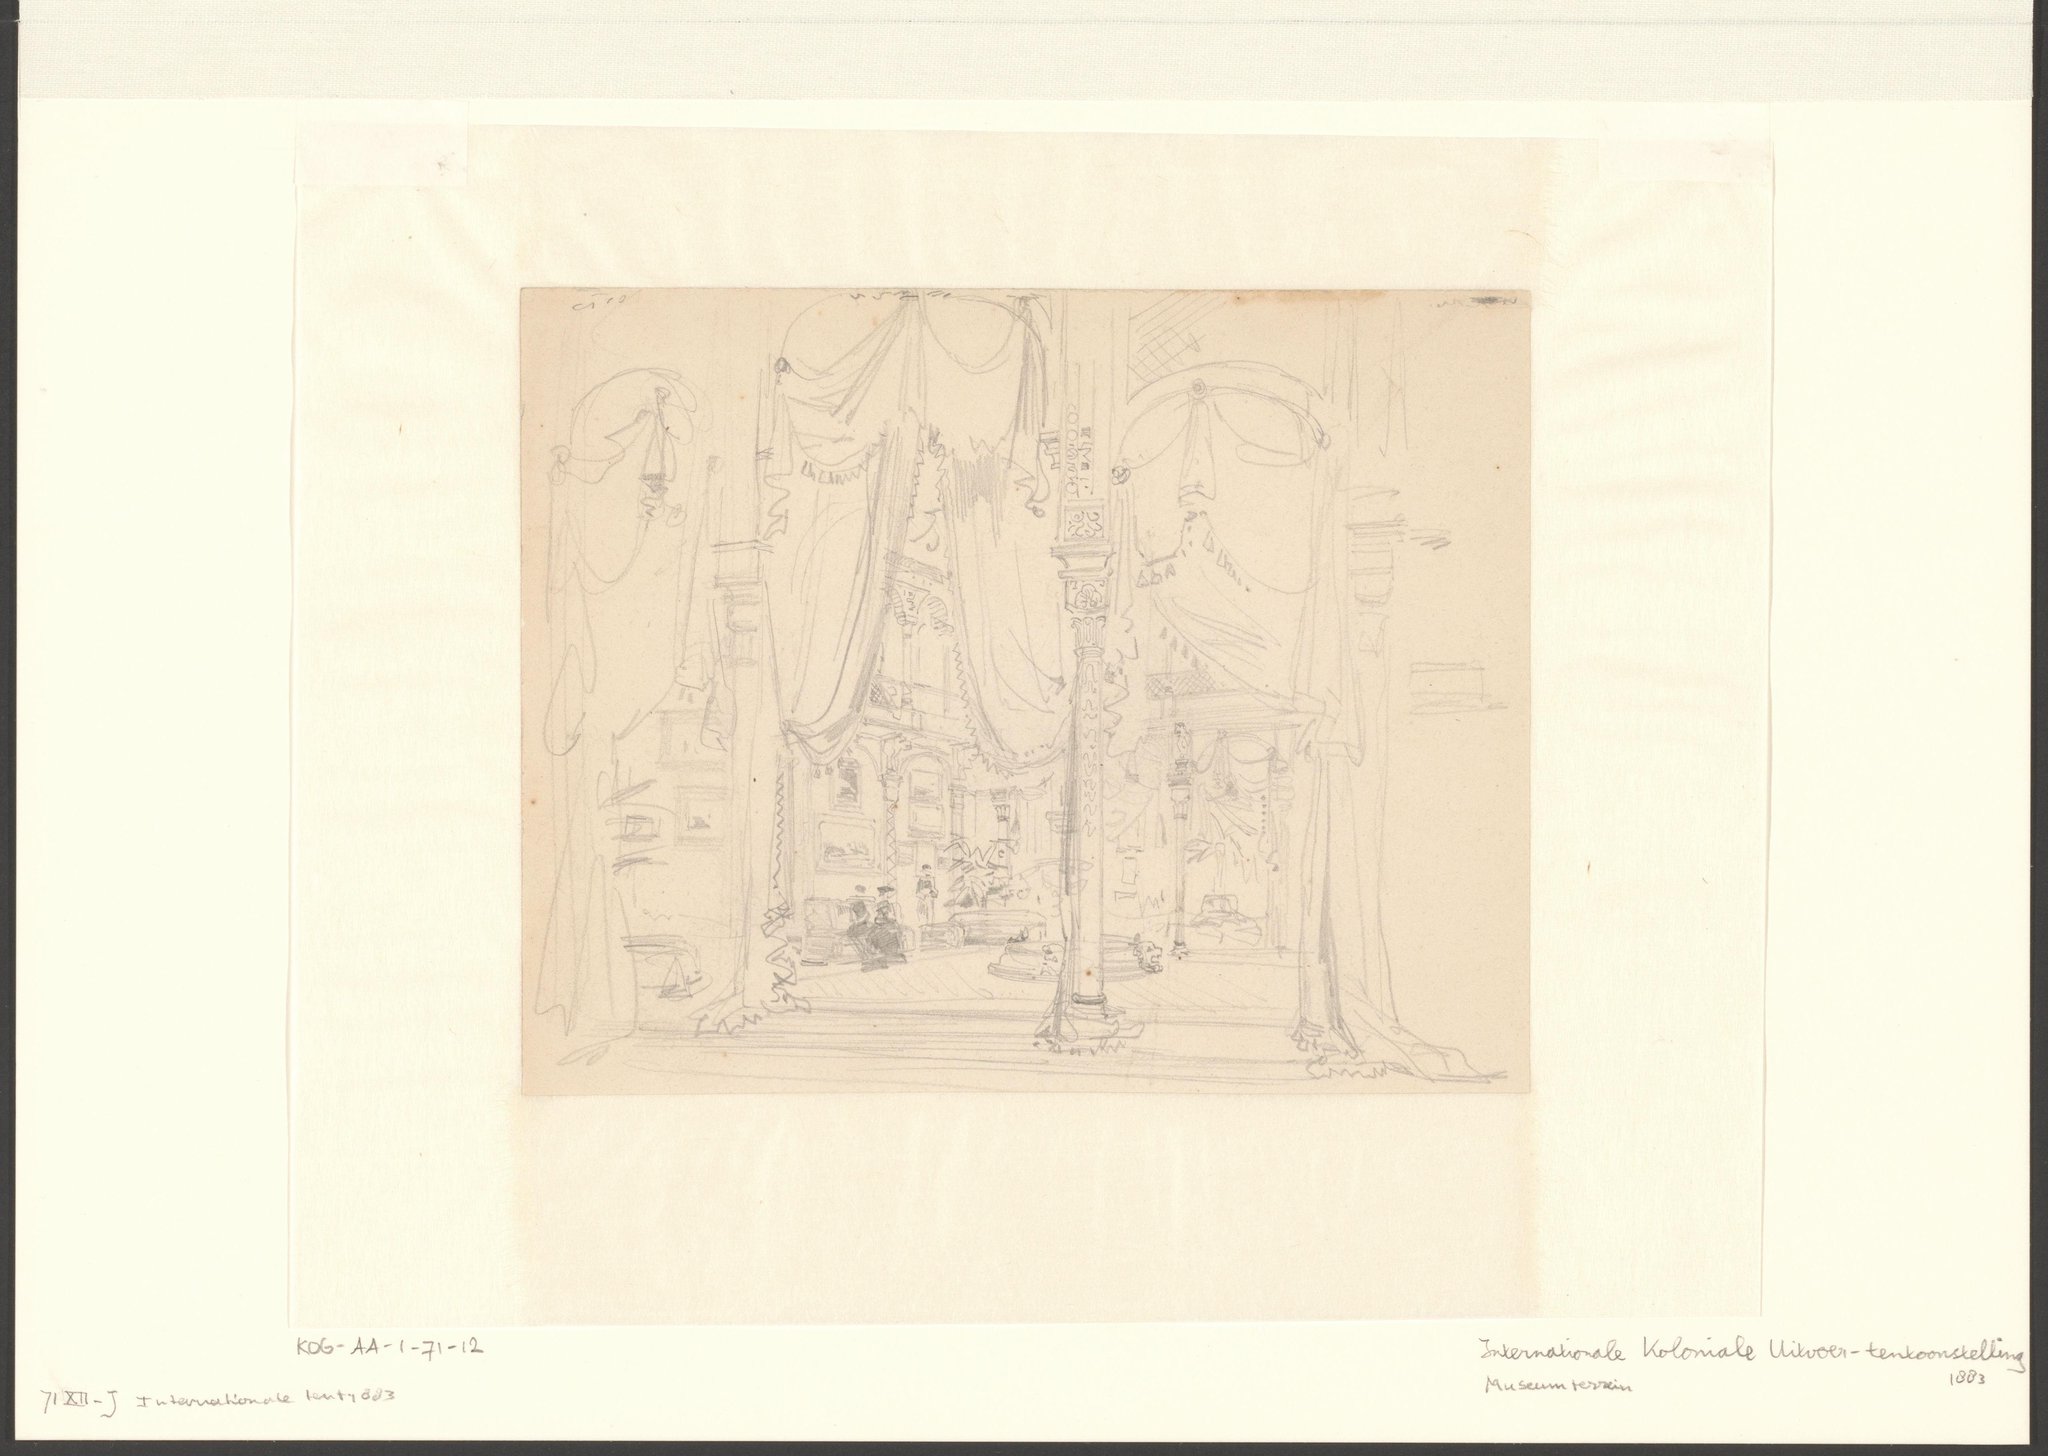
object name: drawing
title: Interieur van de Koloniale Afdeling op de Internationale Koloniale en Uitvoerhandel Tentoonstelling te Amsterdam van 1883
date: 1883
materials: paper, pencil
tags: trade exhibition, industries fair, city-view in general; 'veduta', world fair, world exhibition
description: Onderwerpsrubriek binnen de Atlas Amsterdam: Tentoonstellingen (chronologisch).